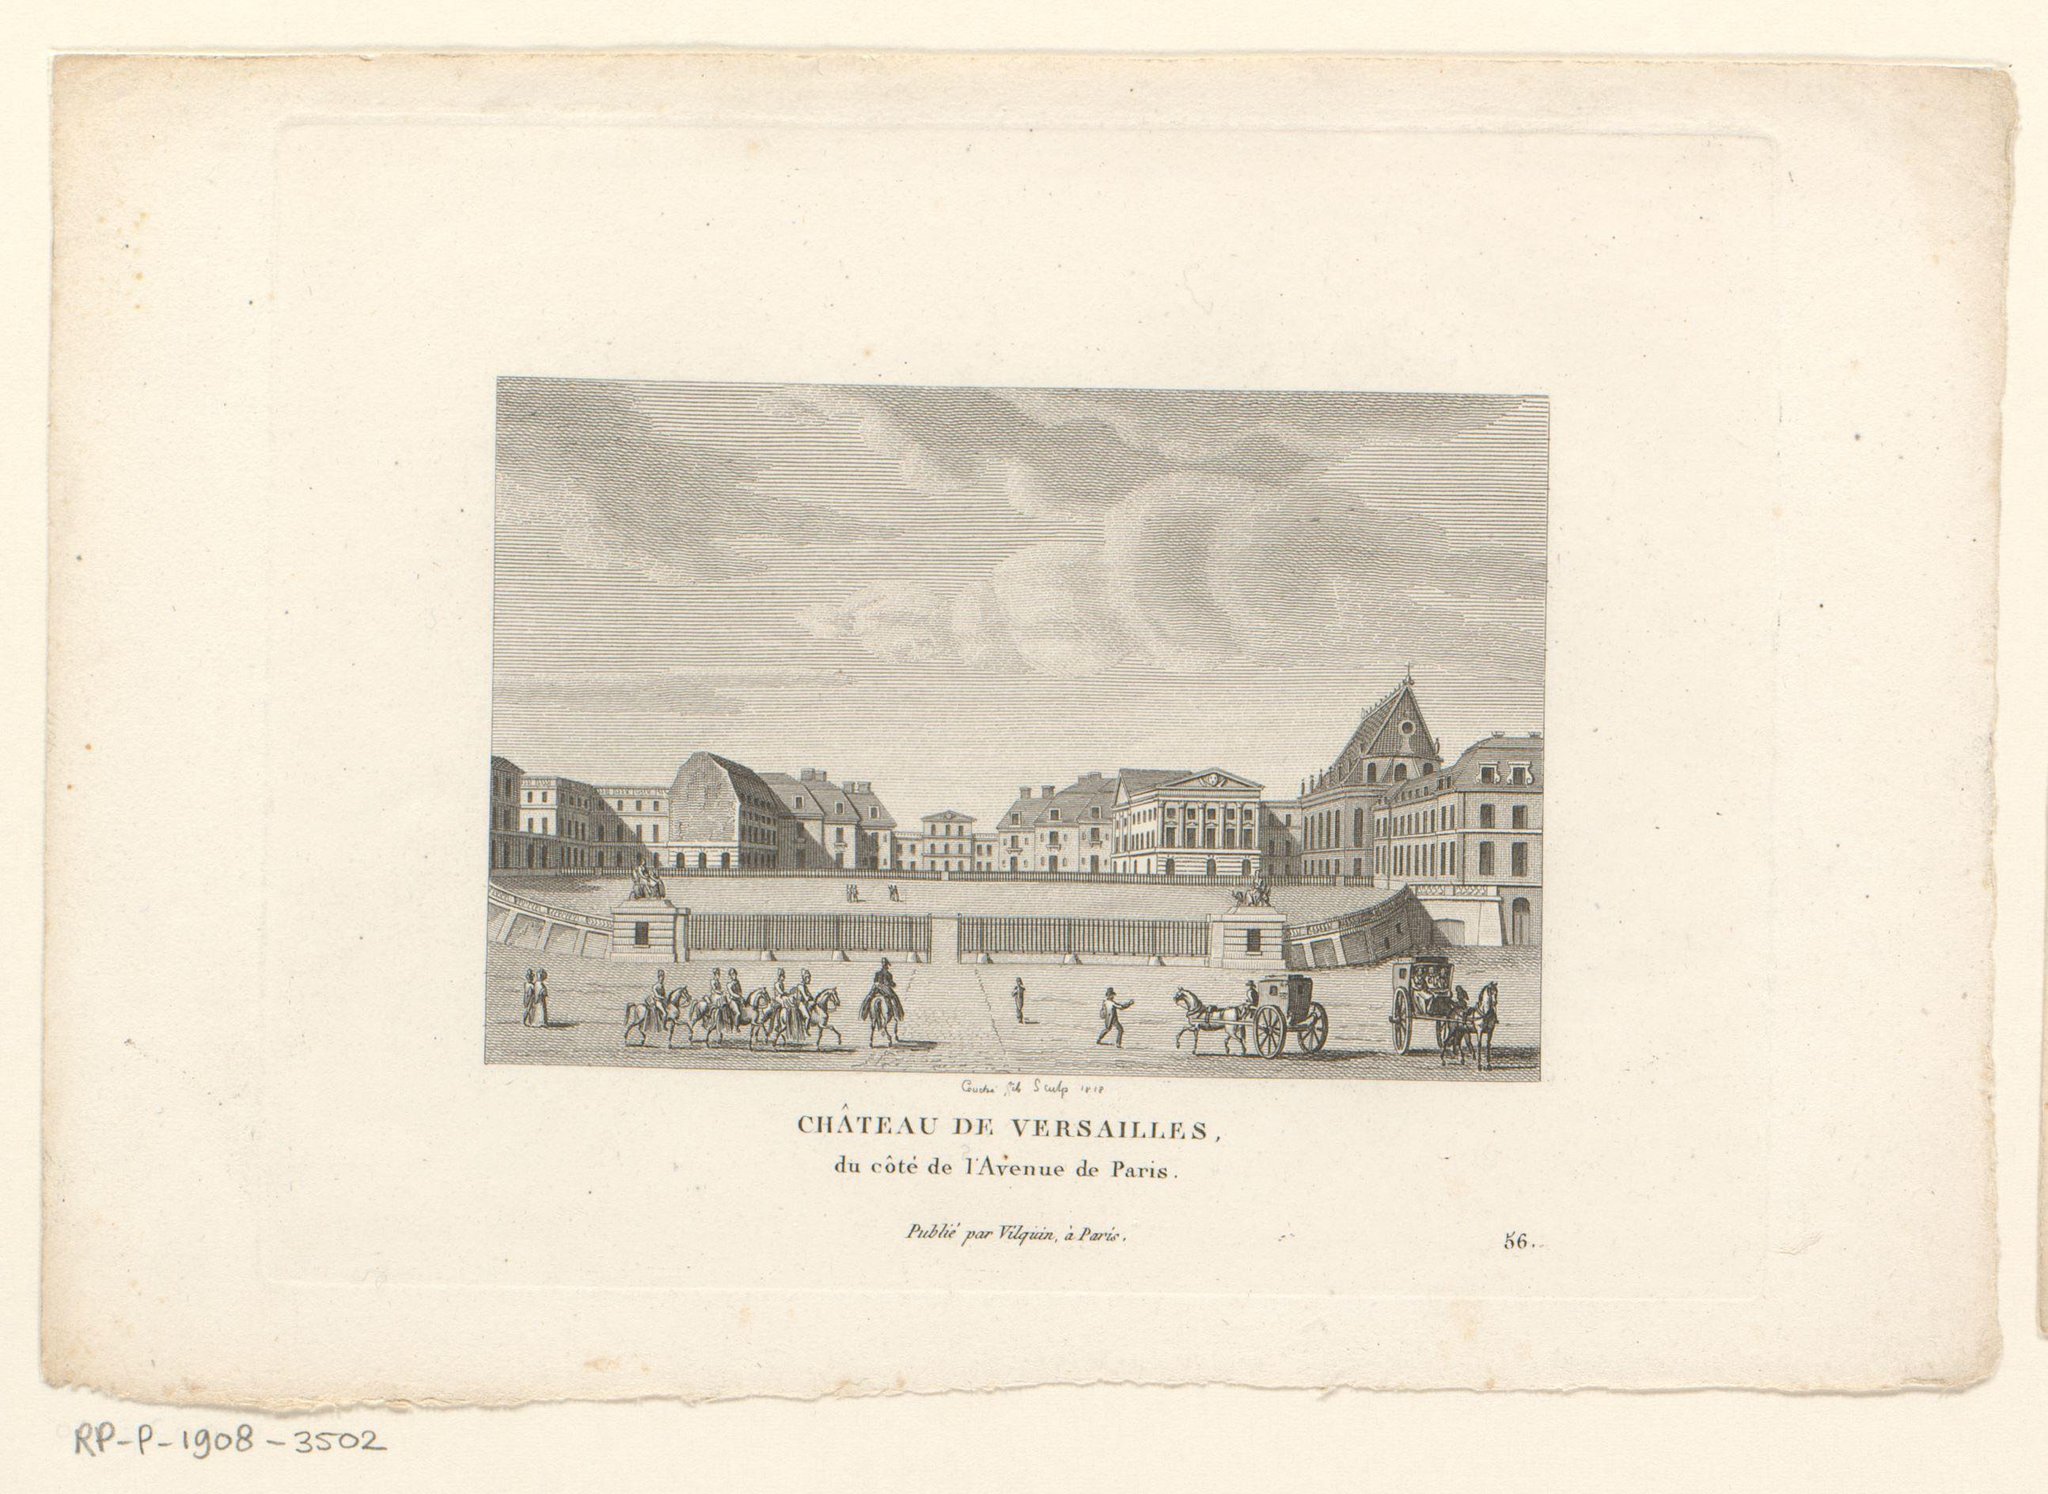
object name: print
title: Château de Versailles.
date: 1818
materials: paper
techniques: etching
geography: paris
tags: city-view in general; 'veduta', palace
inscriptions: collector's mark: Lugt 2228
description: Maakt deel uit van een serie met 60 platen van monumenten, kathedralen en paleizen in Parijs.